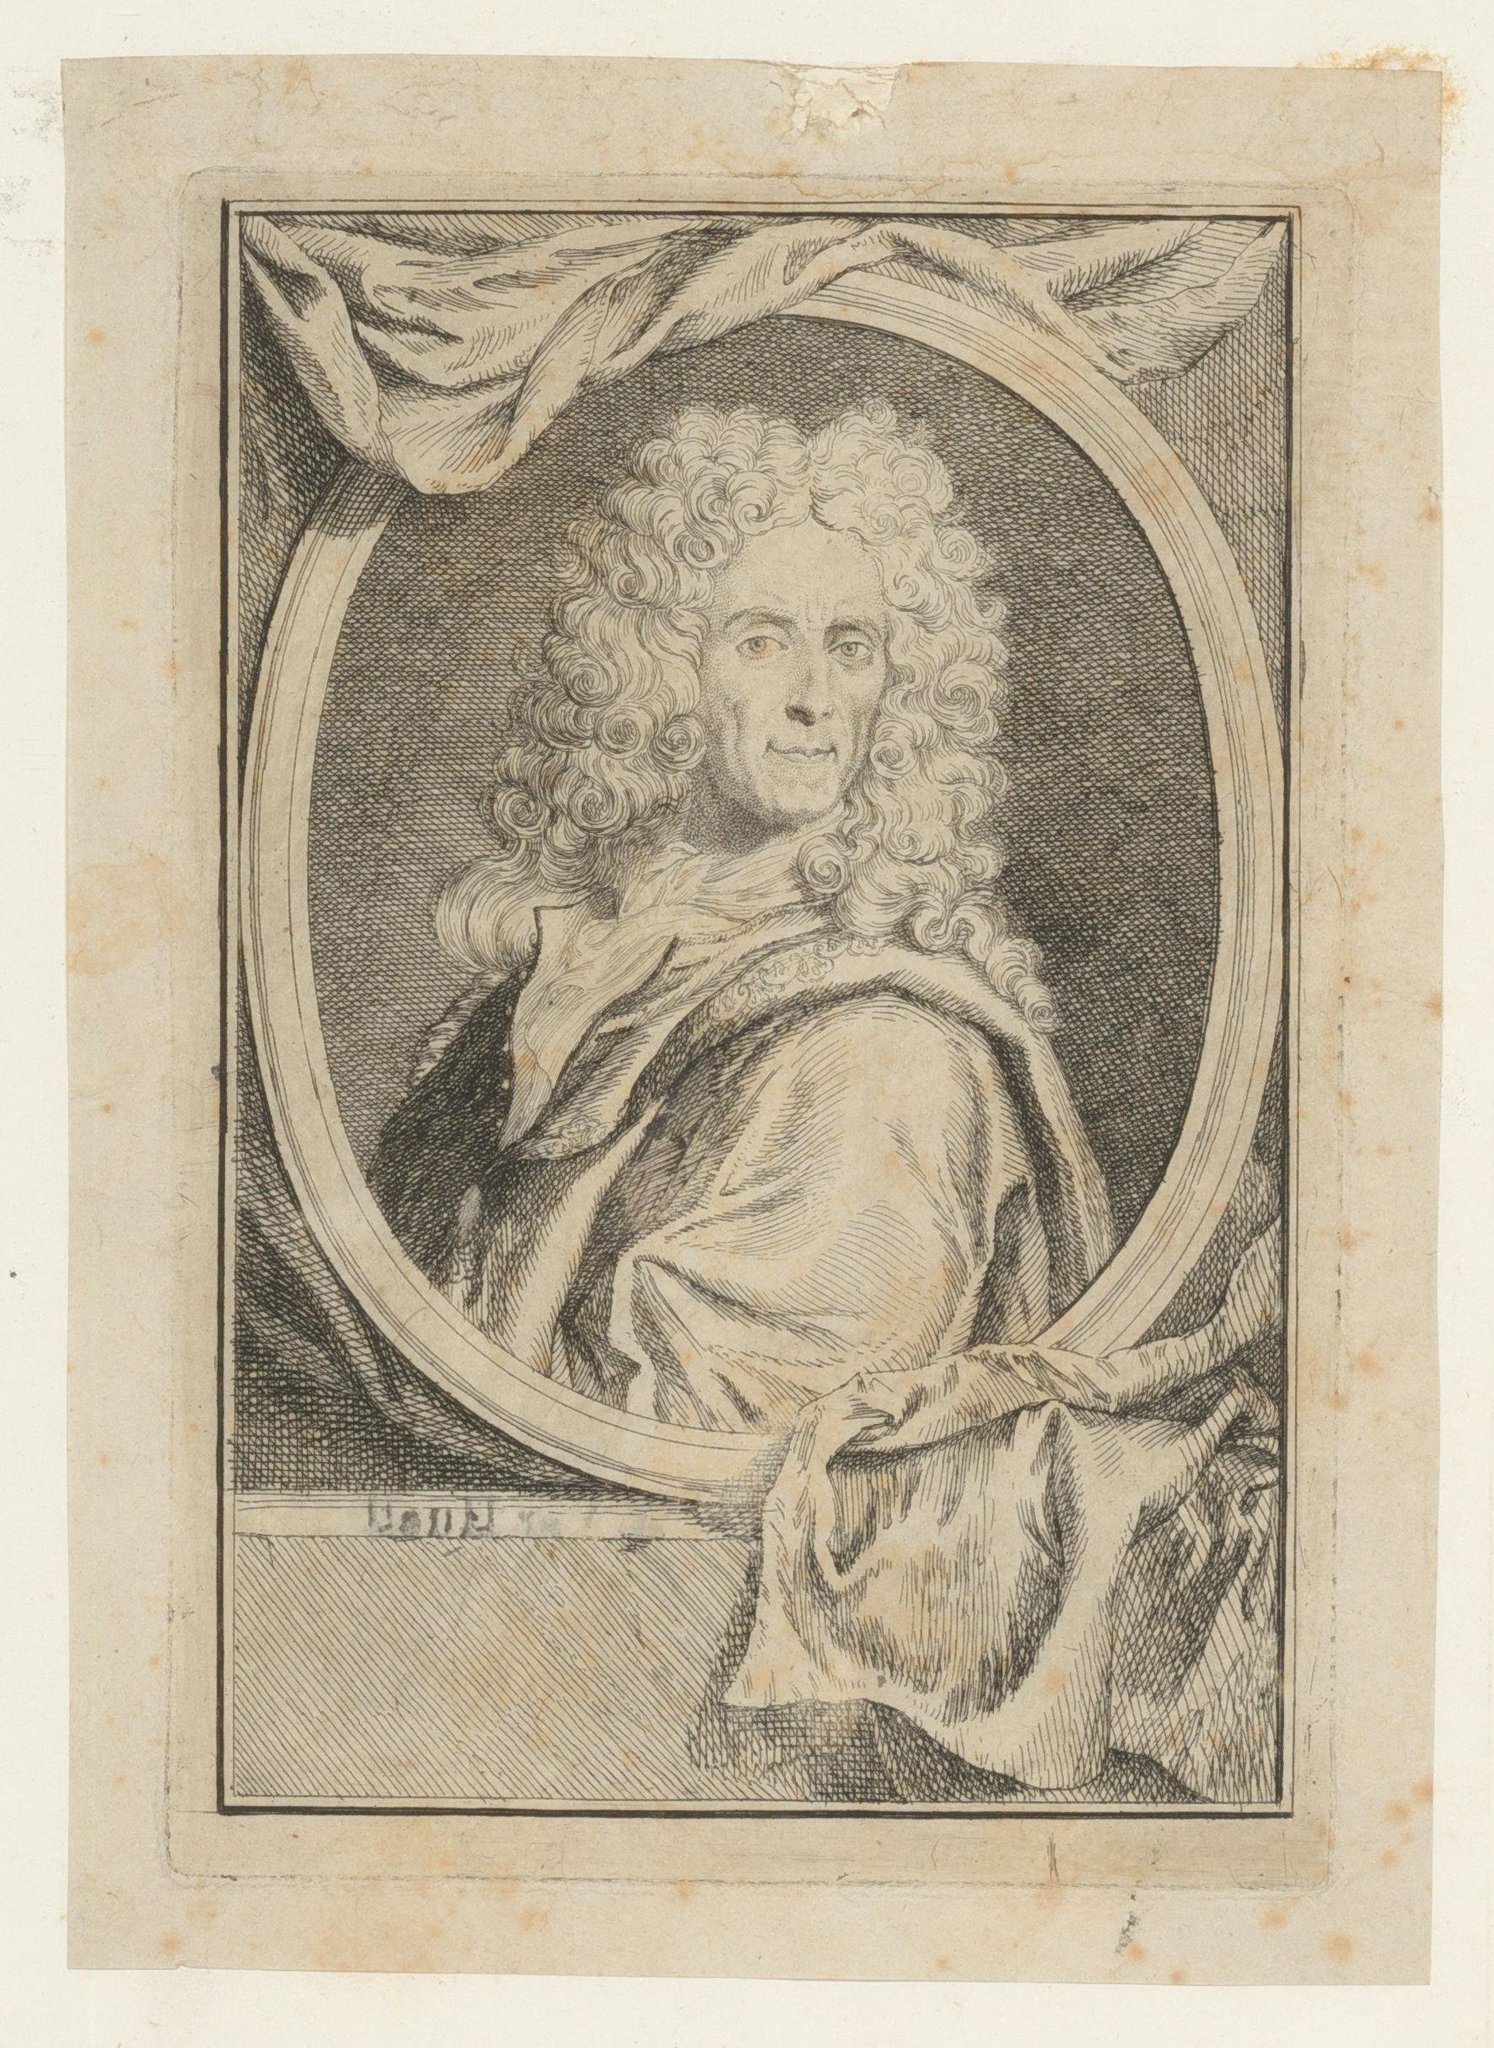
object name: print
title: Portret van Gerard Wigmana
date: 1727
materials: paper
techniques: engraving, etching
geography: netherlands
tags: amsterdam, gerard wigmana, historical persons, portrait, self-portrait of painter, portrait, self-portrait of artist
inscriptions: collector's mark: Lugt 2488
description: Portret van de Friese prentmaker Gerard Wigmana, buste in ovaal.